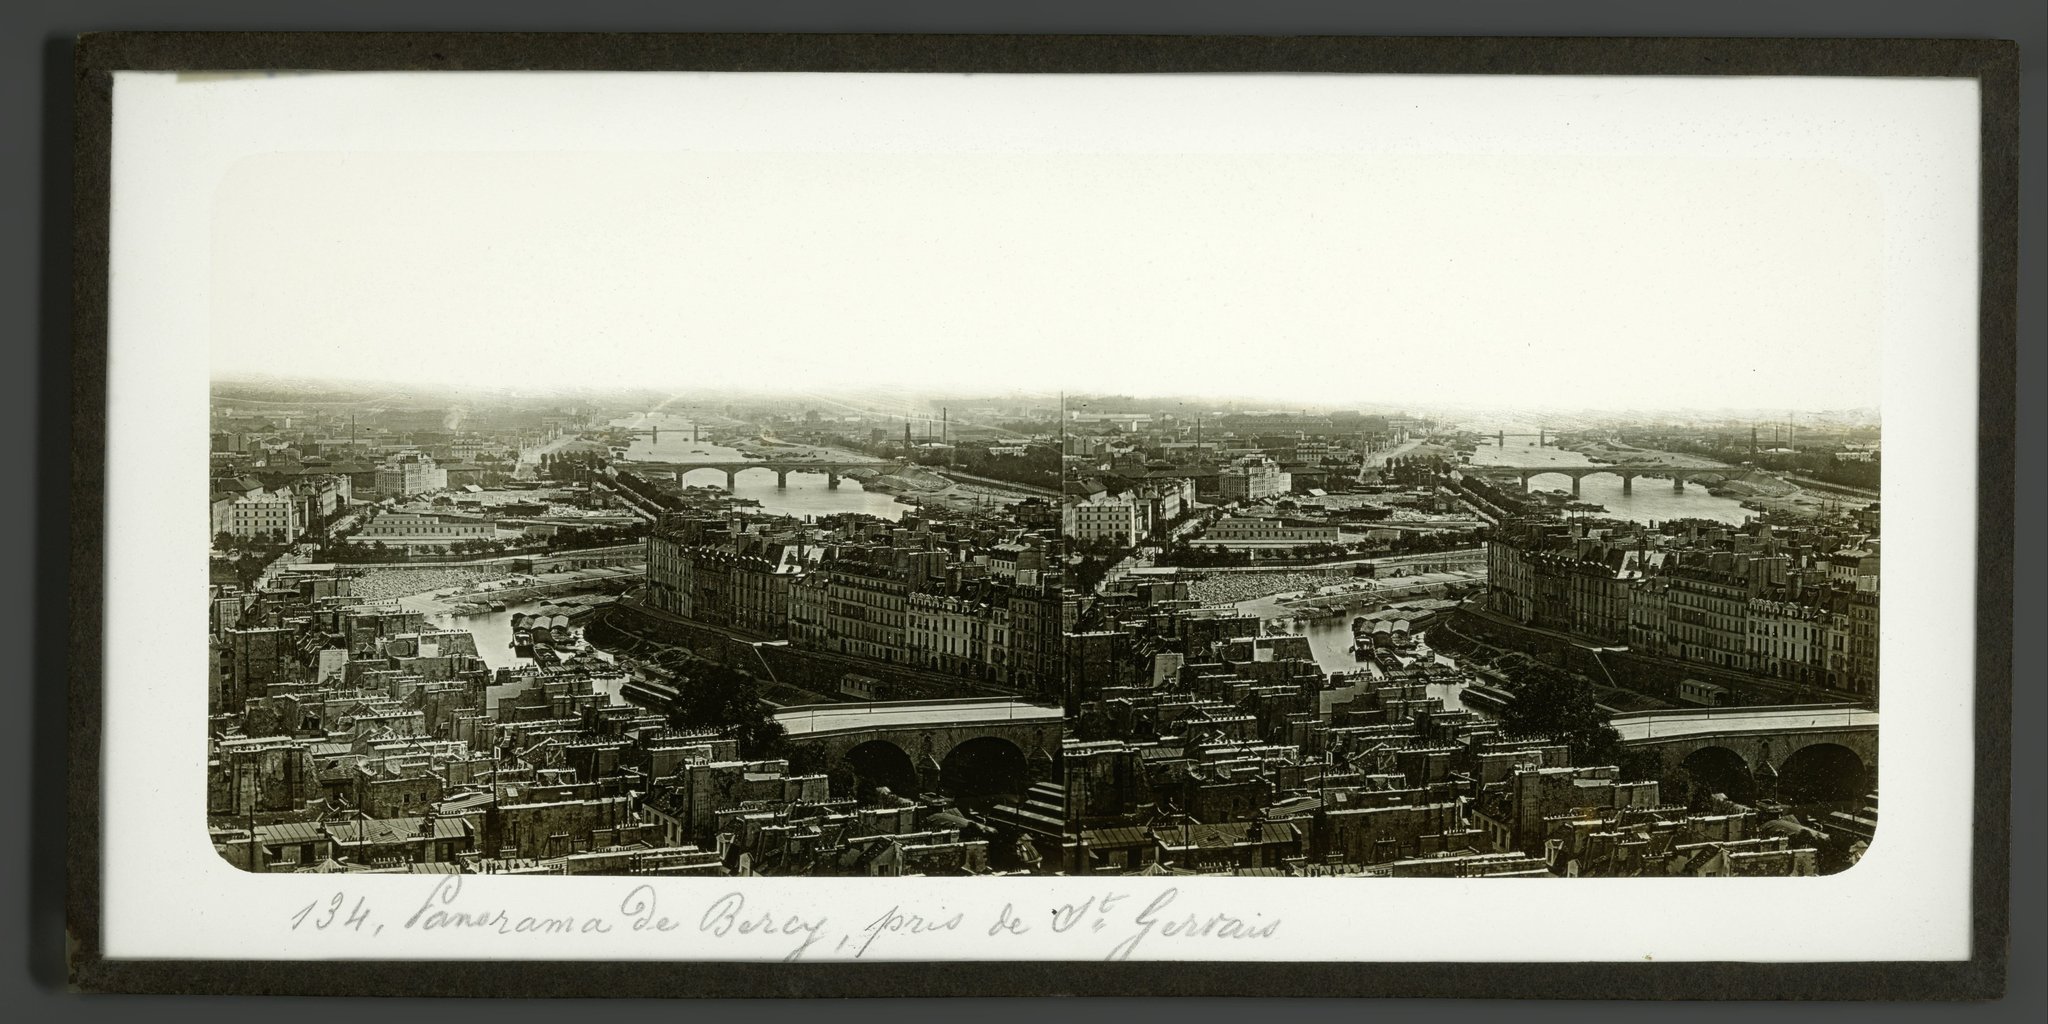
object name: stereoscopic photograph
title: Gezicht op de wijk Bercy te Parijs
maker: Anonymous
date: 1856-1890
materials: glass, paper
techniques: slide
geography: paris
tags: city-view in general; 'veduta', paris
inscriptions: annotation: ‘134, Panorama De Bercy, pris de St. Gervais’